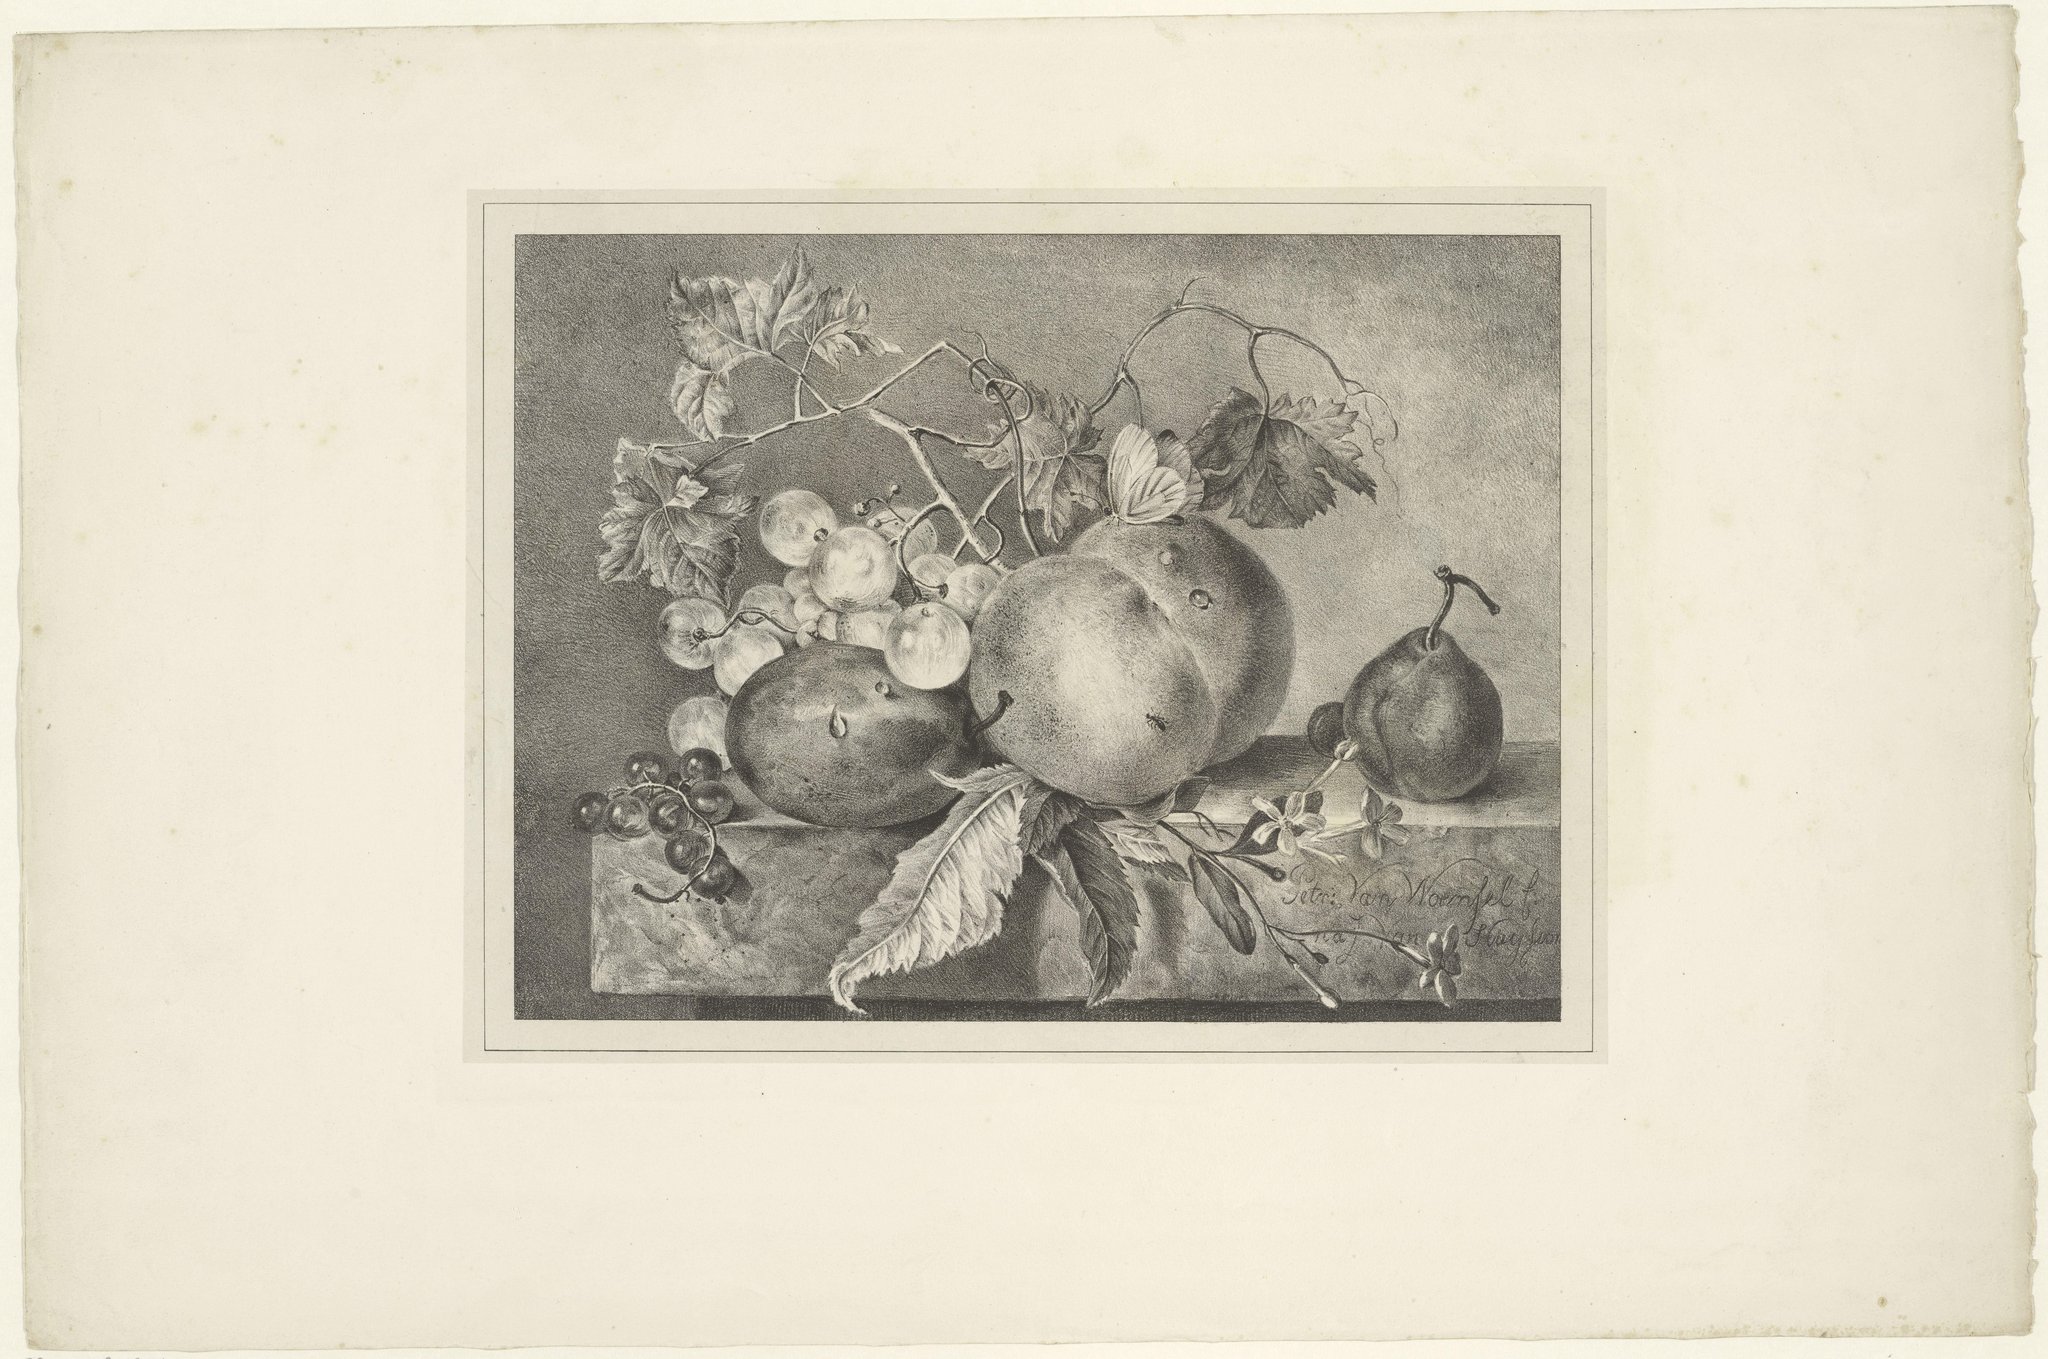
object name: print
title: Vruchtenstilleven op een marmeren blad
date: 1809-1839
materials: paper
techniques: lithograph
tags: insects: butterfly, still life of plants, flowers and fruit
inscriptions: collector's mark: Lugt 2228